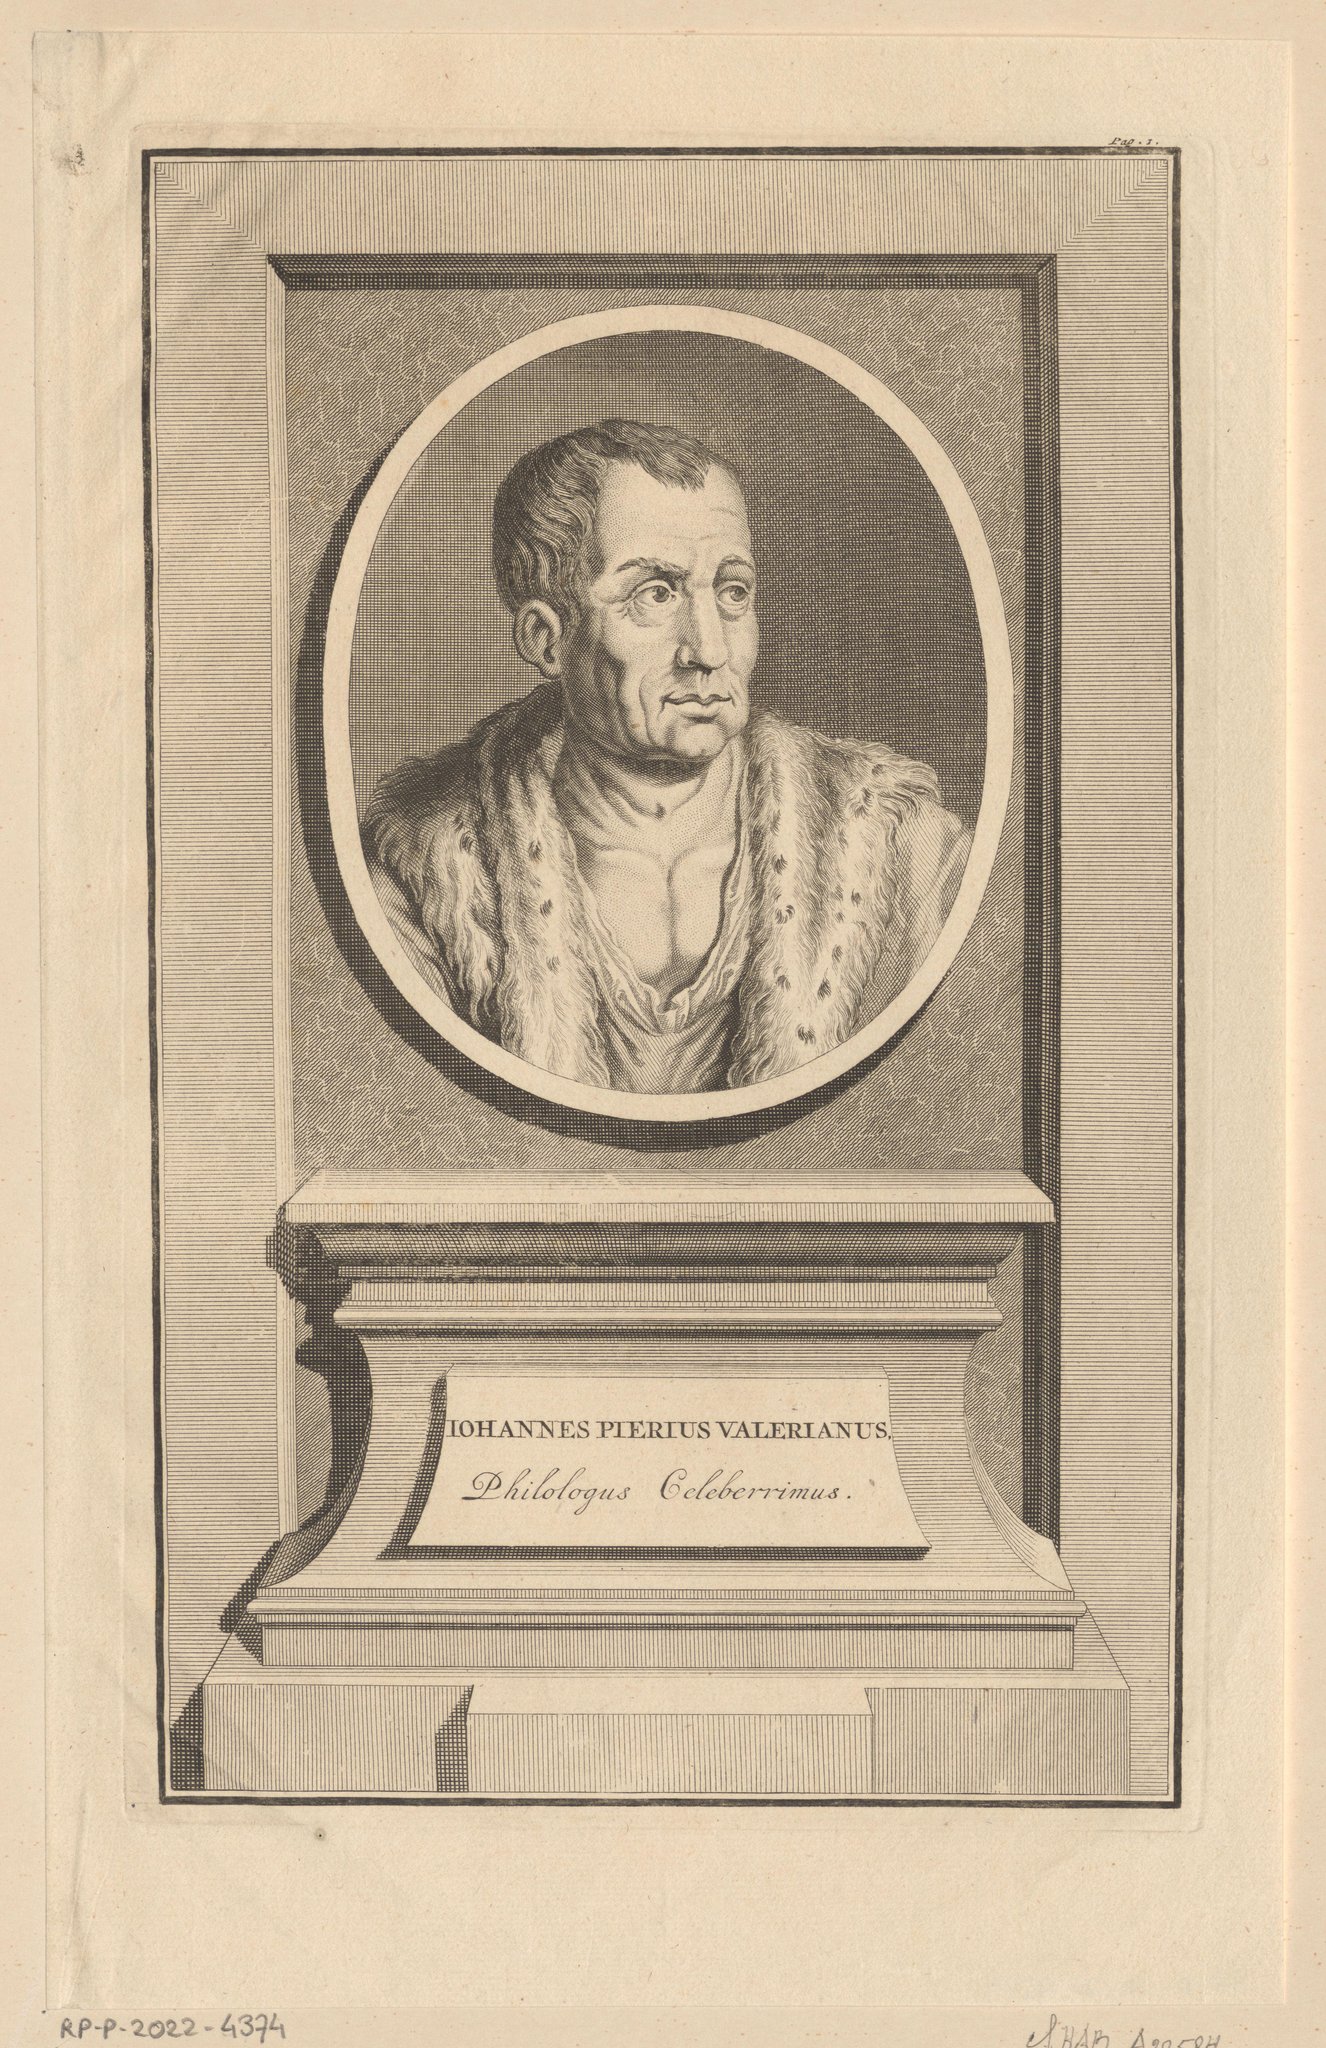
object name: print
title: Portret van Giampietro Valeriano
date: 1720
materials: paper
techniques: etching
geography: leiden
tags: historical persons, writer, poet, author